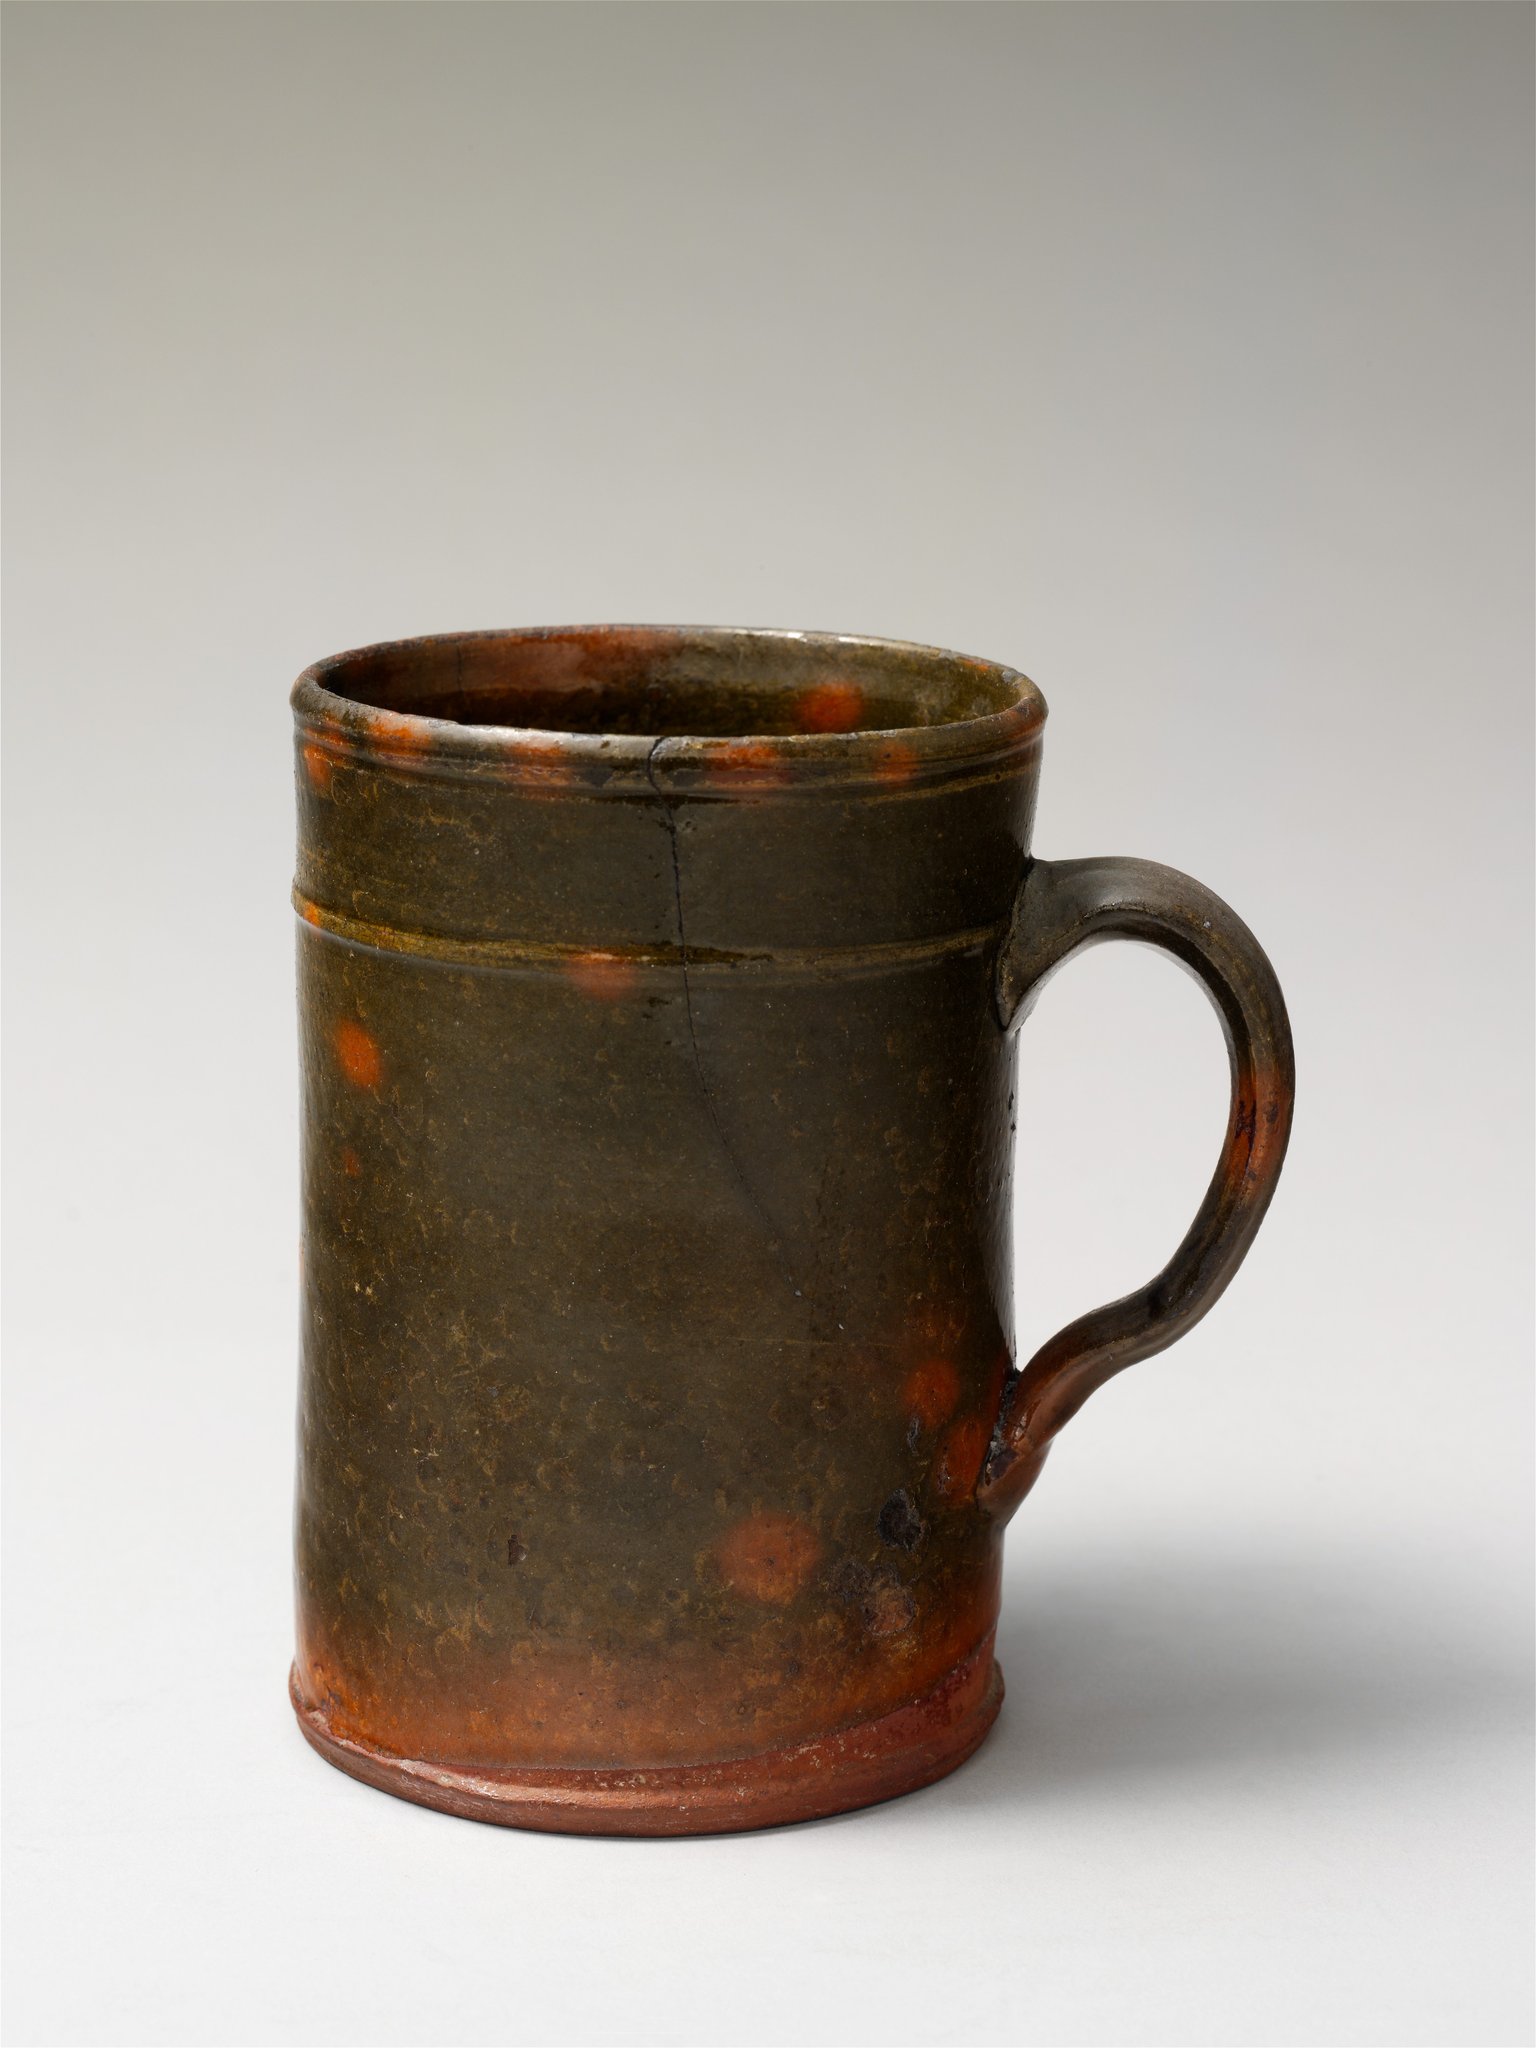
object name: mug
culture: american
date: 1770-1800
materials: earthenware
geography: united states